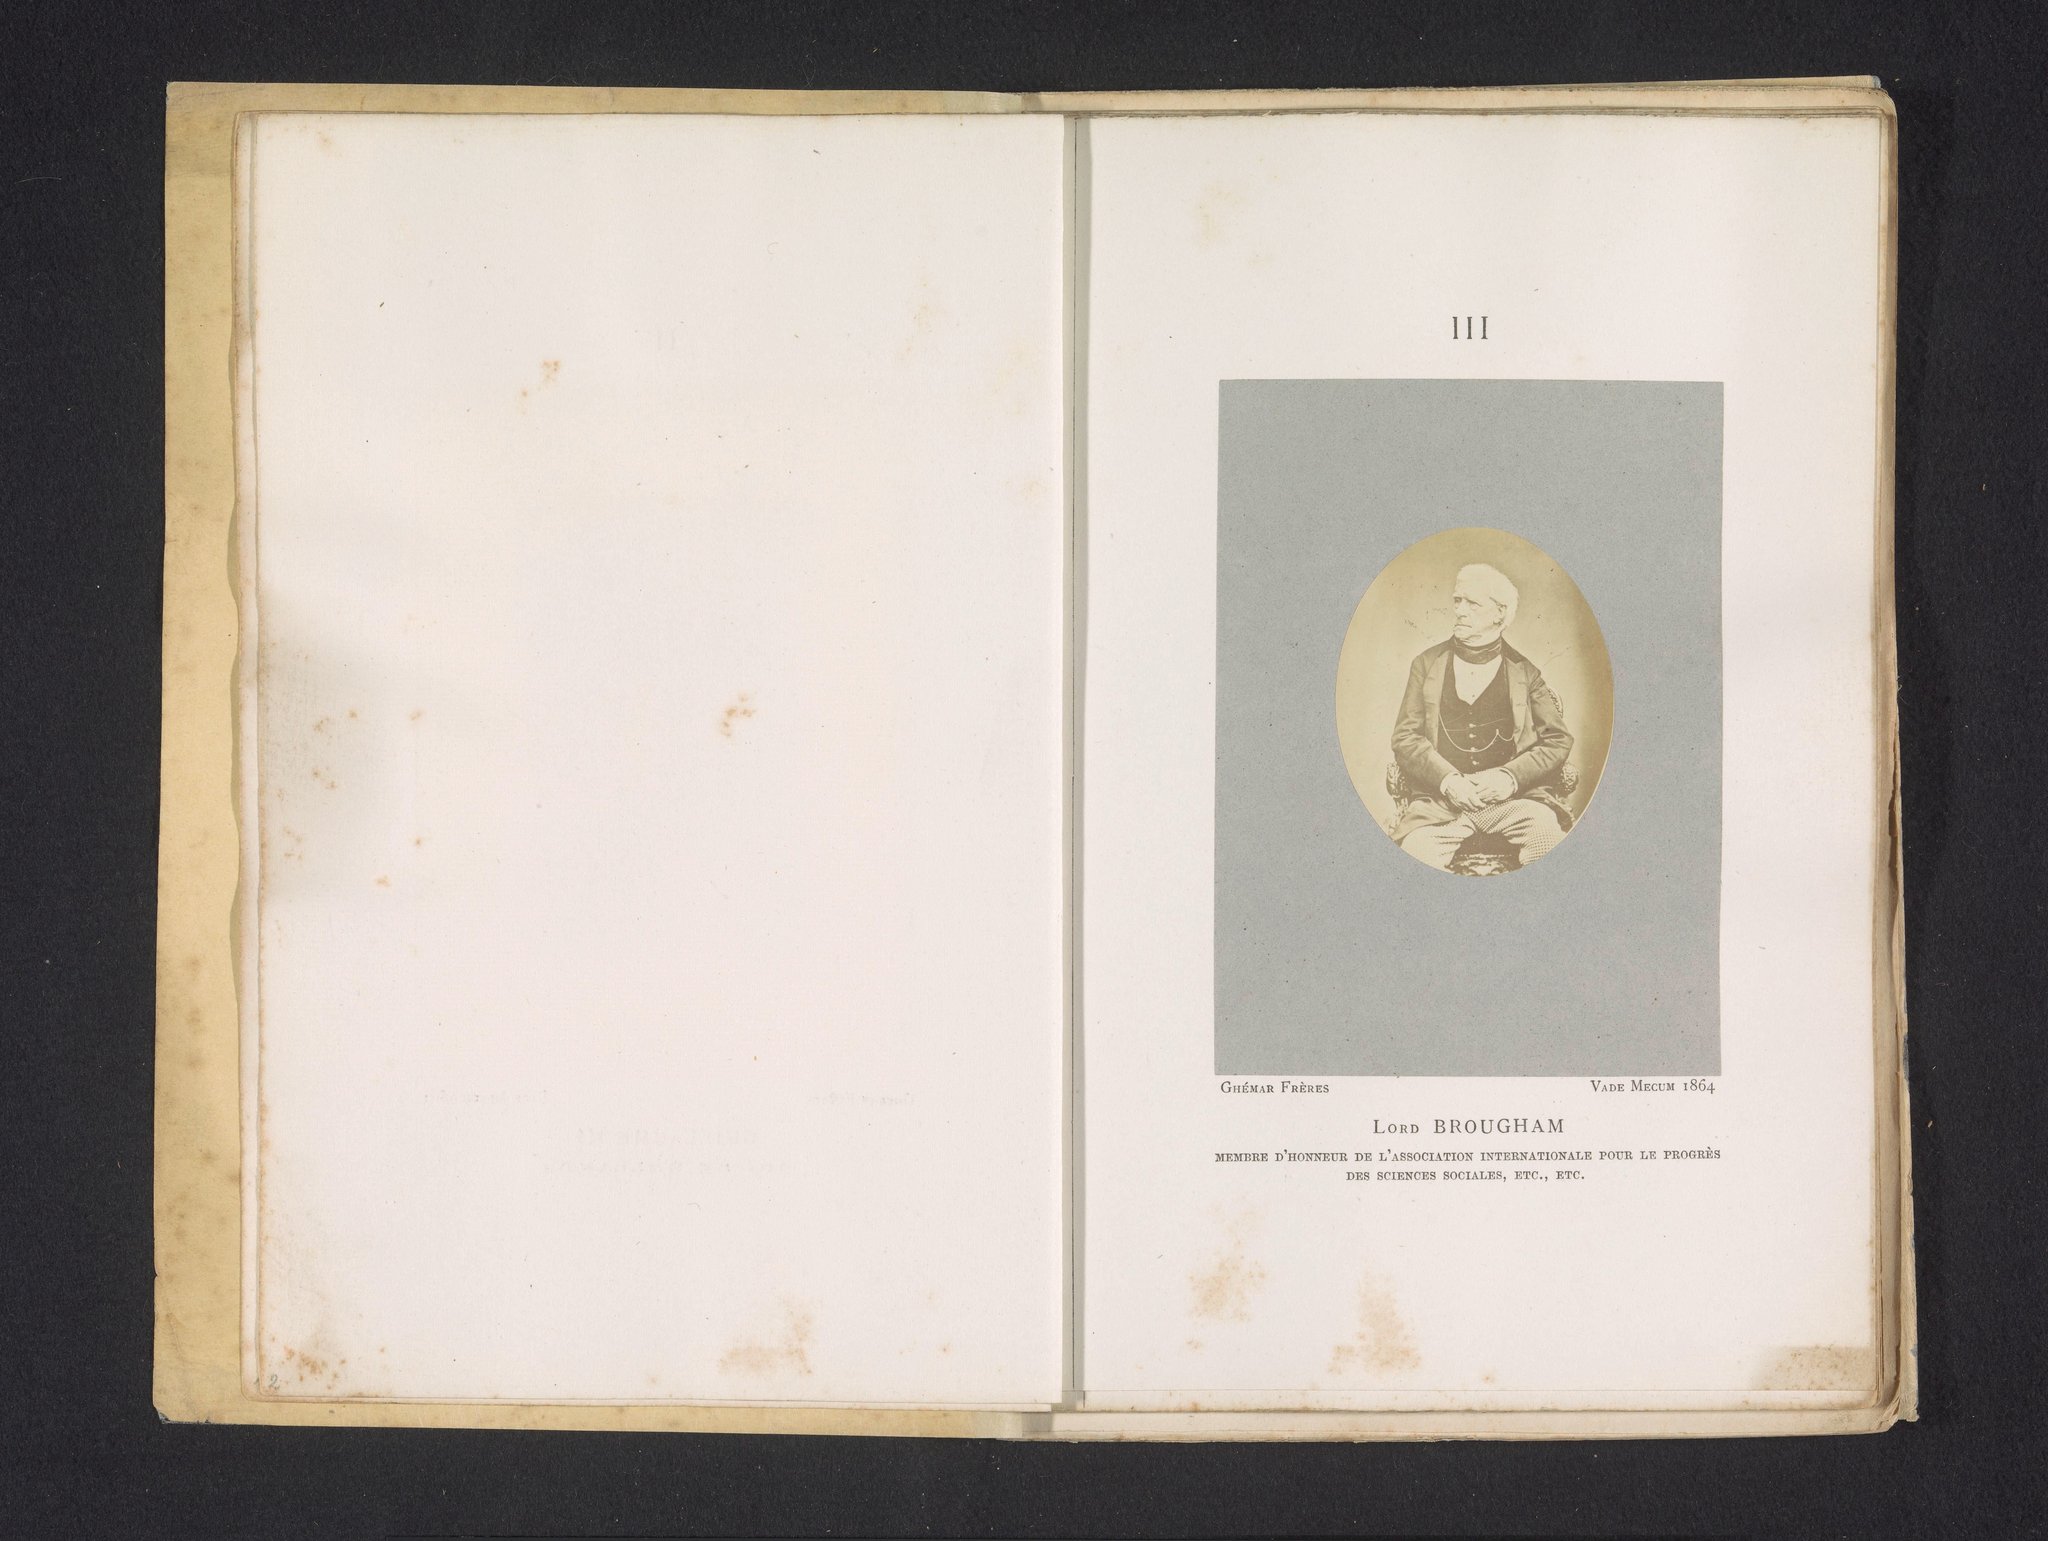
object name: page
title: Lord Brougham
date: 1860-1865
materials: photographic support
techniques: albumen print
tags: politician, historical persons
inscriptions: inscription: ‘Vade Mecum 1864’, inscription: ‘Membre d'honneur de l'Association Internationale pour le Progrès/ des Sciences Sociales, etc., etc.’, number: ‘III’